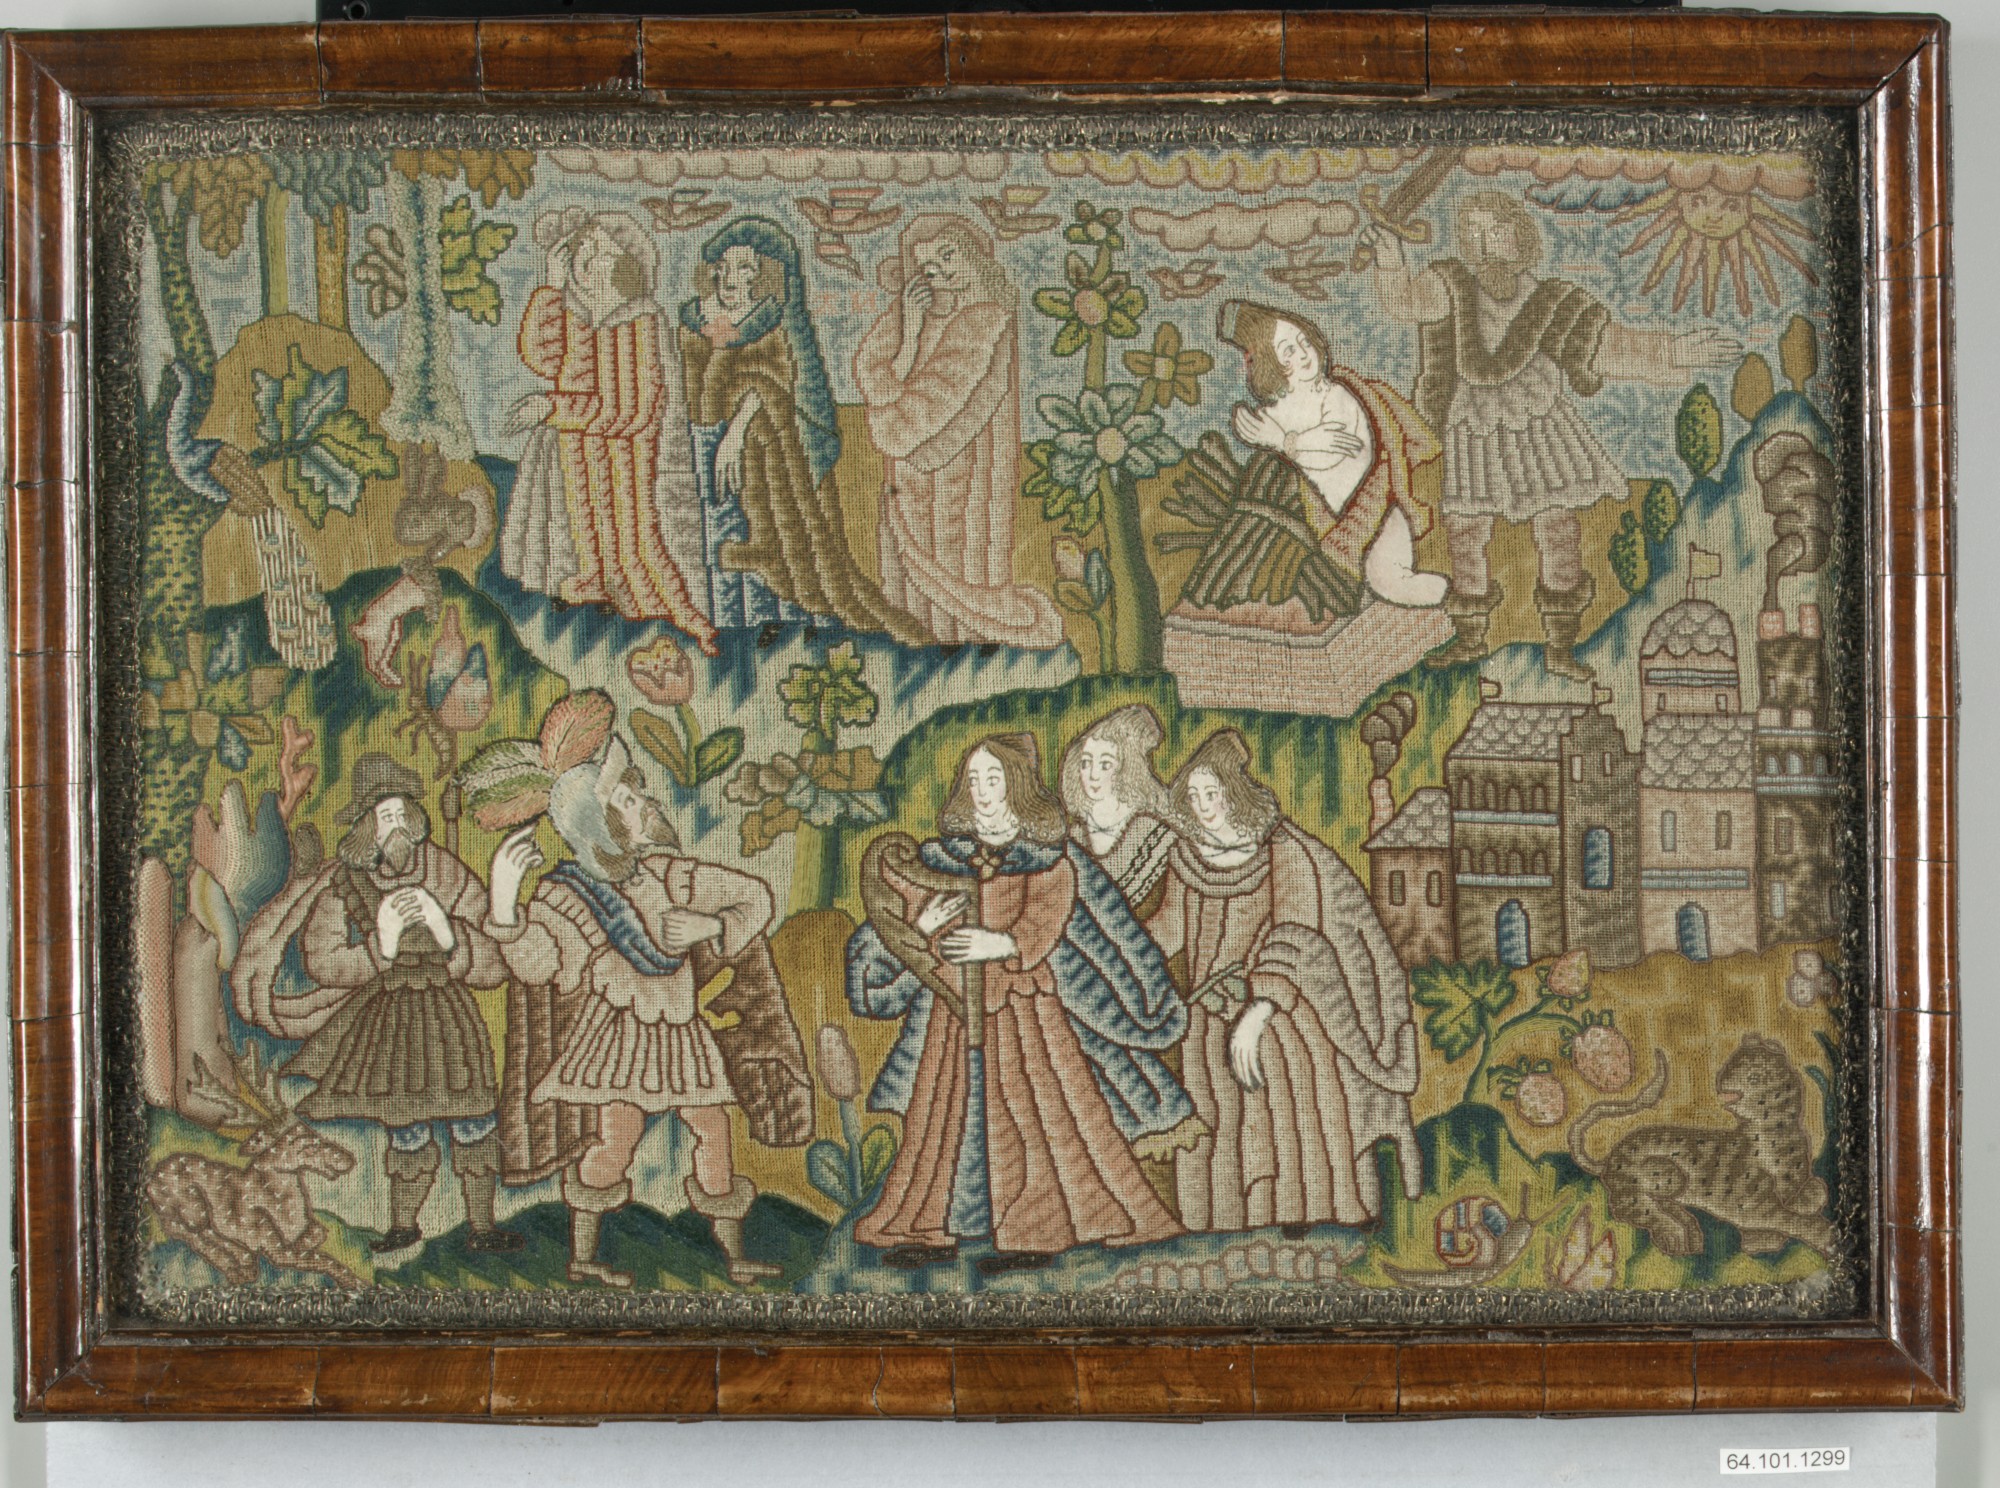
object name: embroidered picture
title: Jepthah and His Daughter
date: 1651-1675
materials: canvas, silk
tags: houses,men,women,peacocks,deer,butterflies,snails,flowers